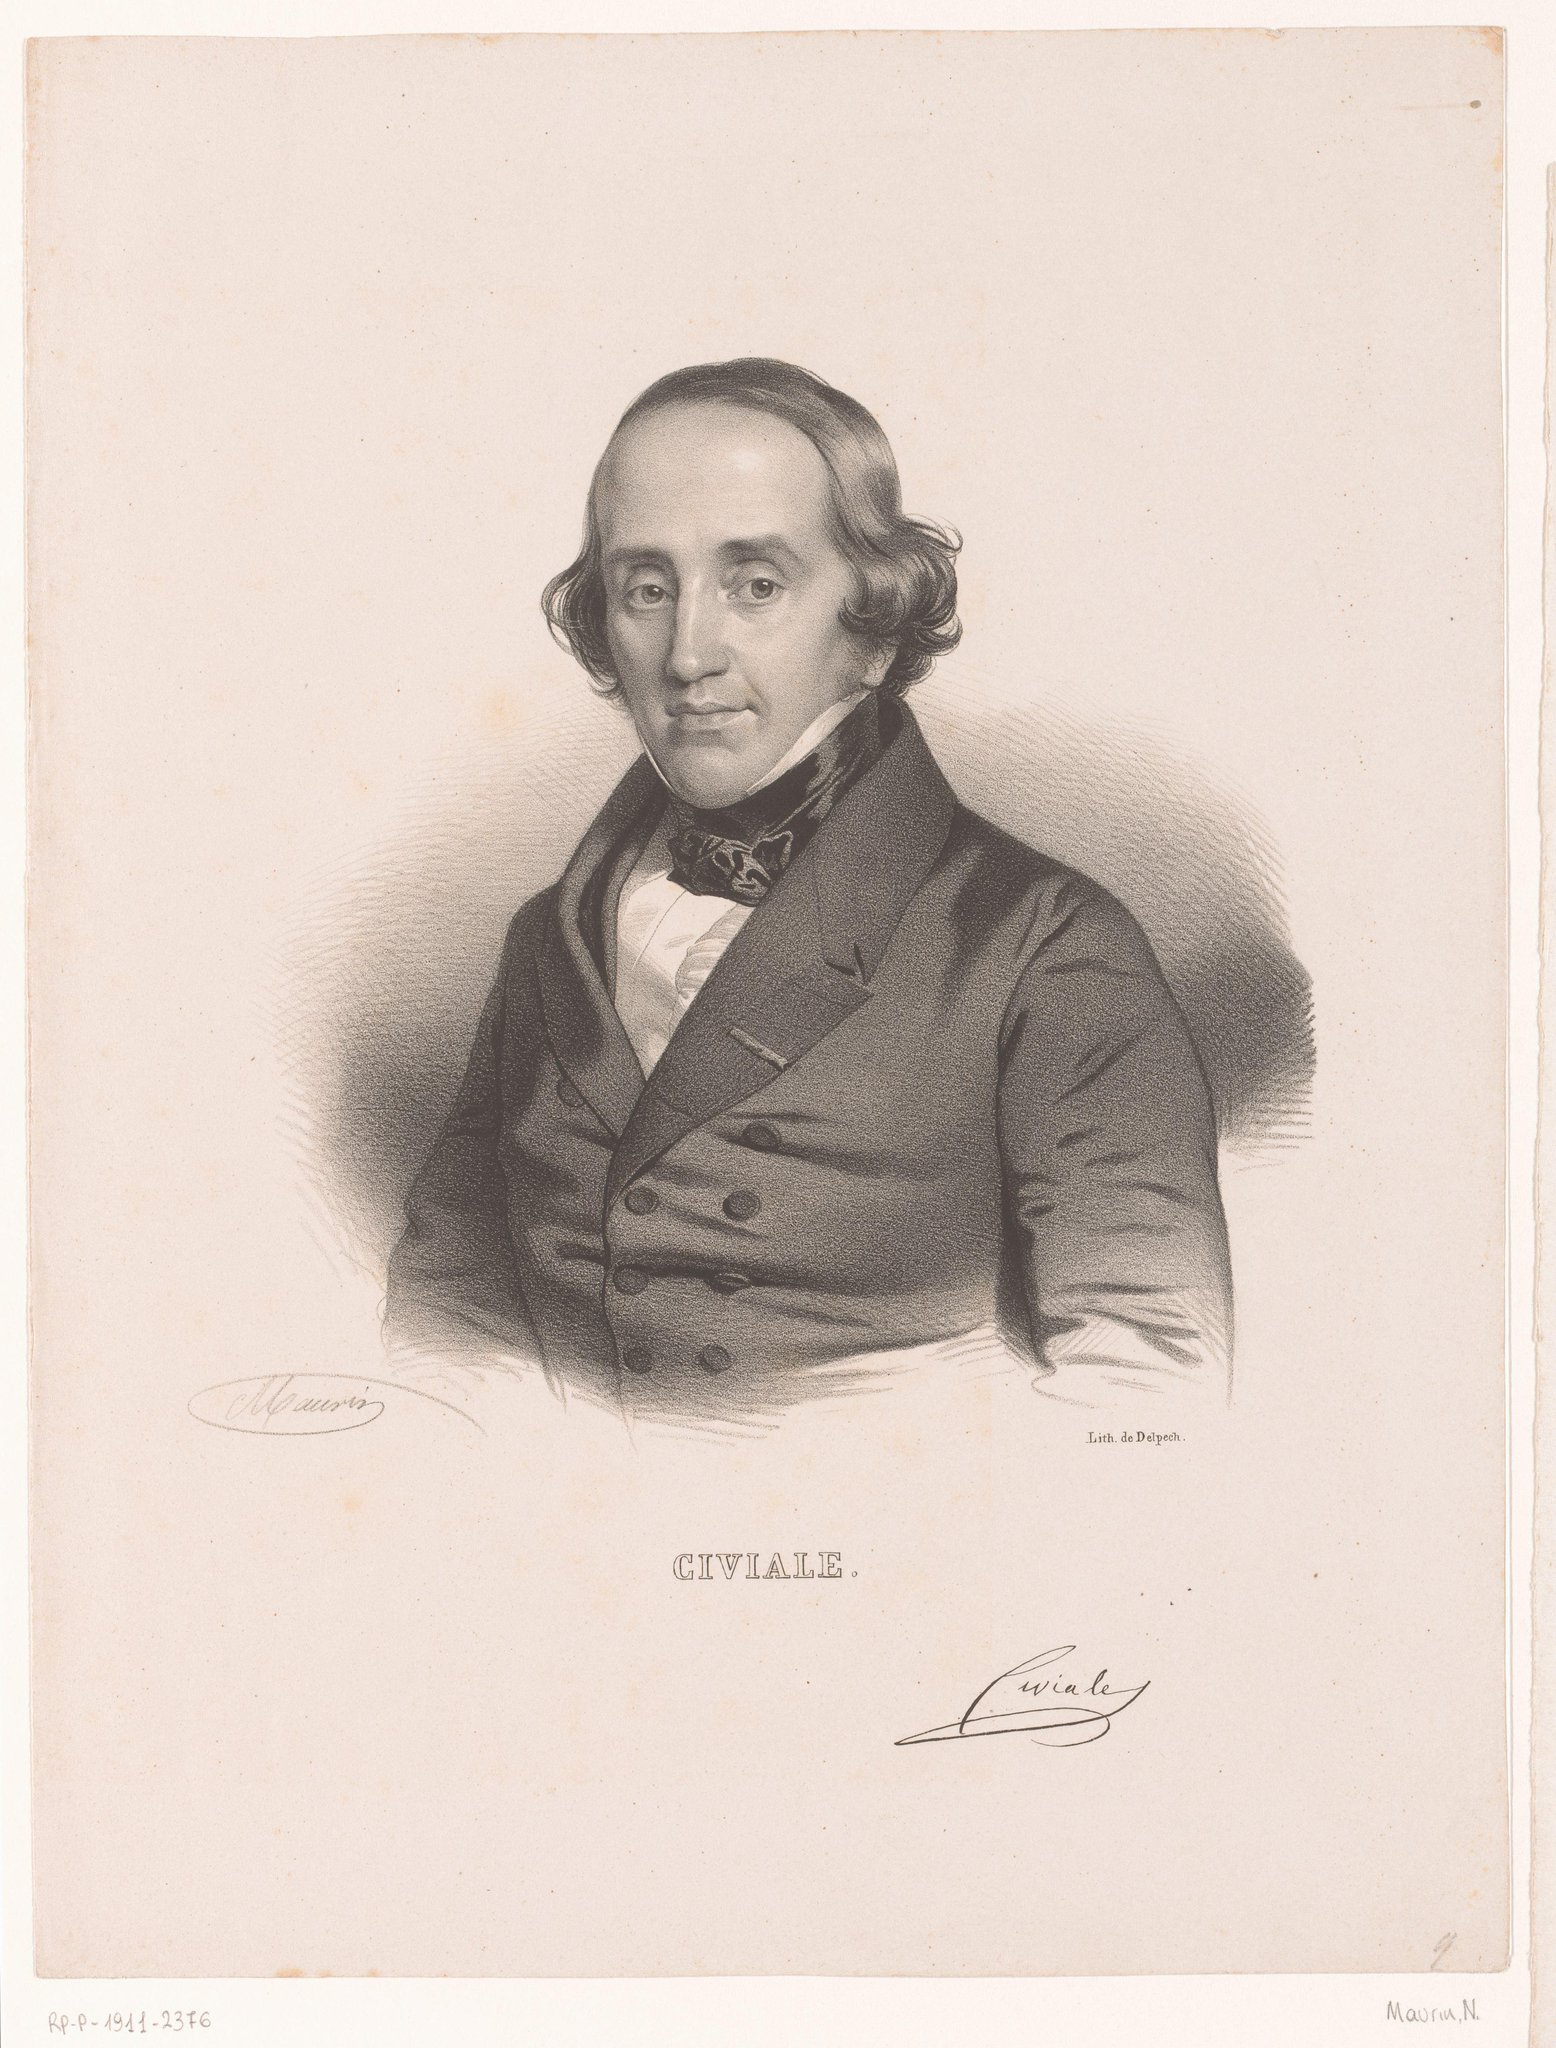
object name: print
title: Portret van Jean Civiale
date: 1825-1842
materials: paper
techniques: lithograph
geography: paris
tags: paris, historical persons, physician, doctor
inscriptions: collector's mark: Lugt 2228